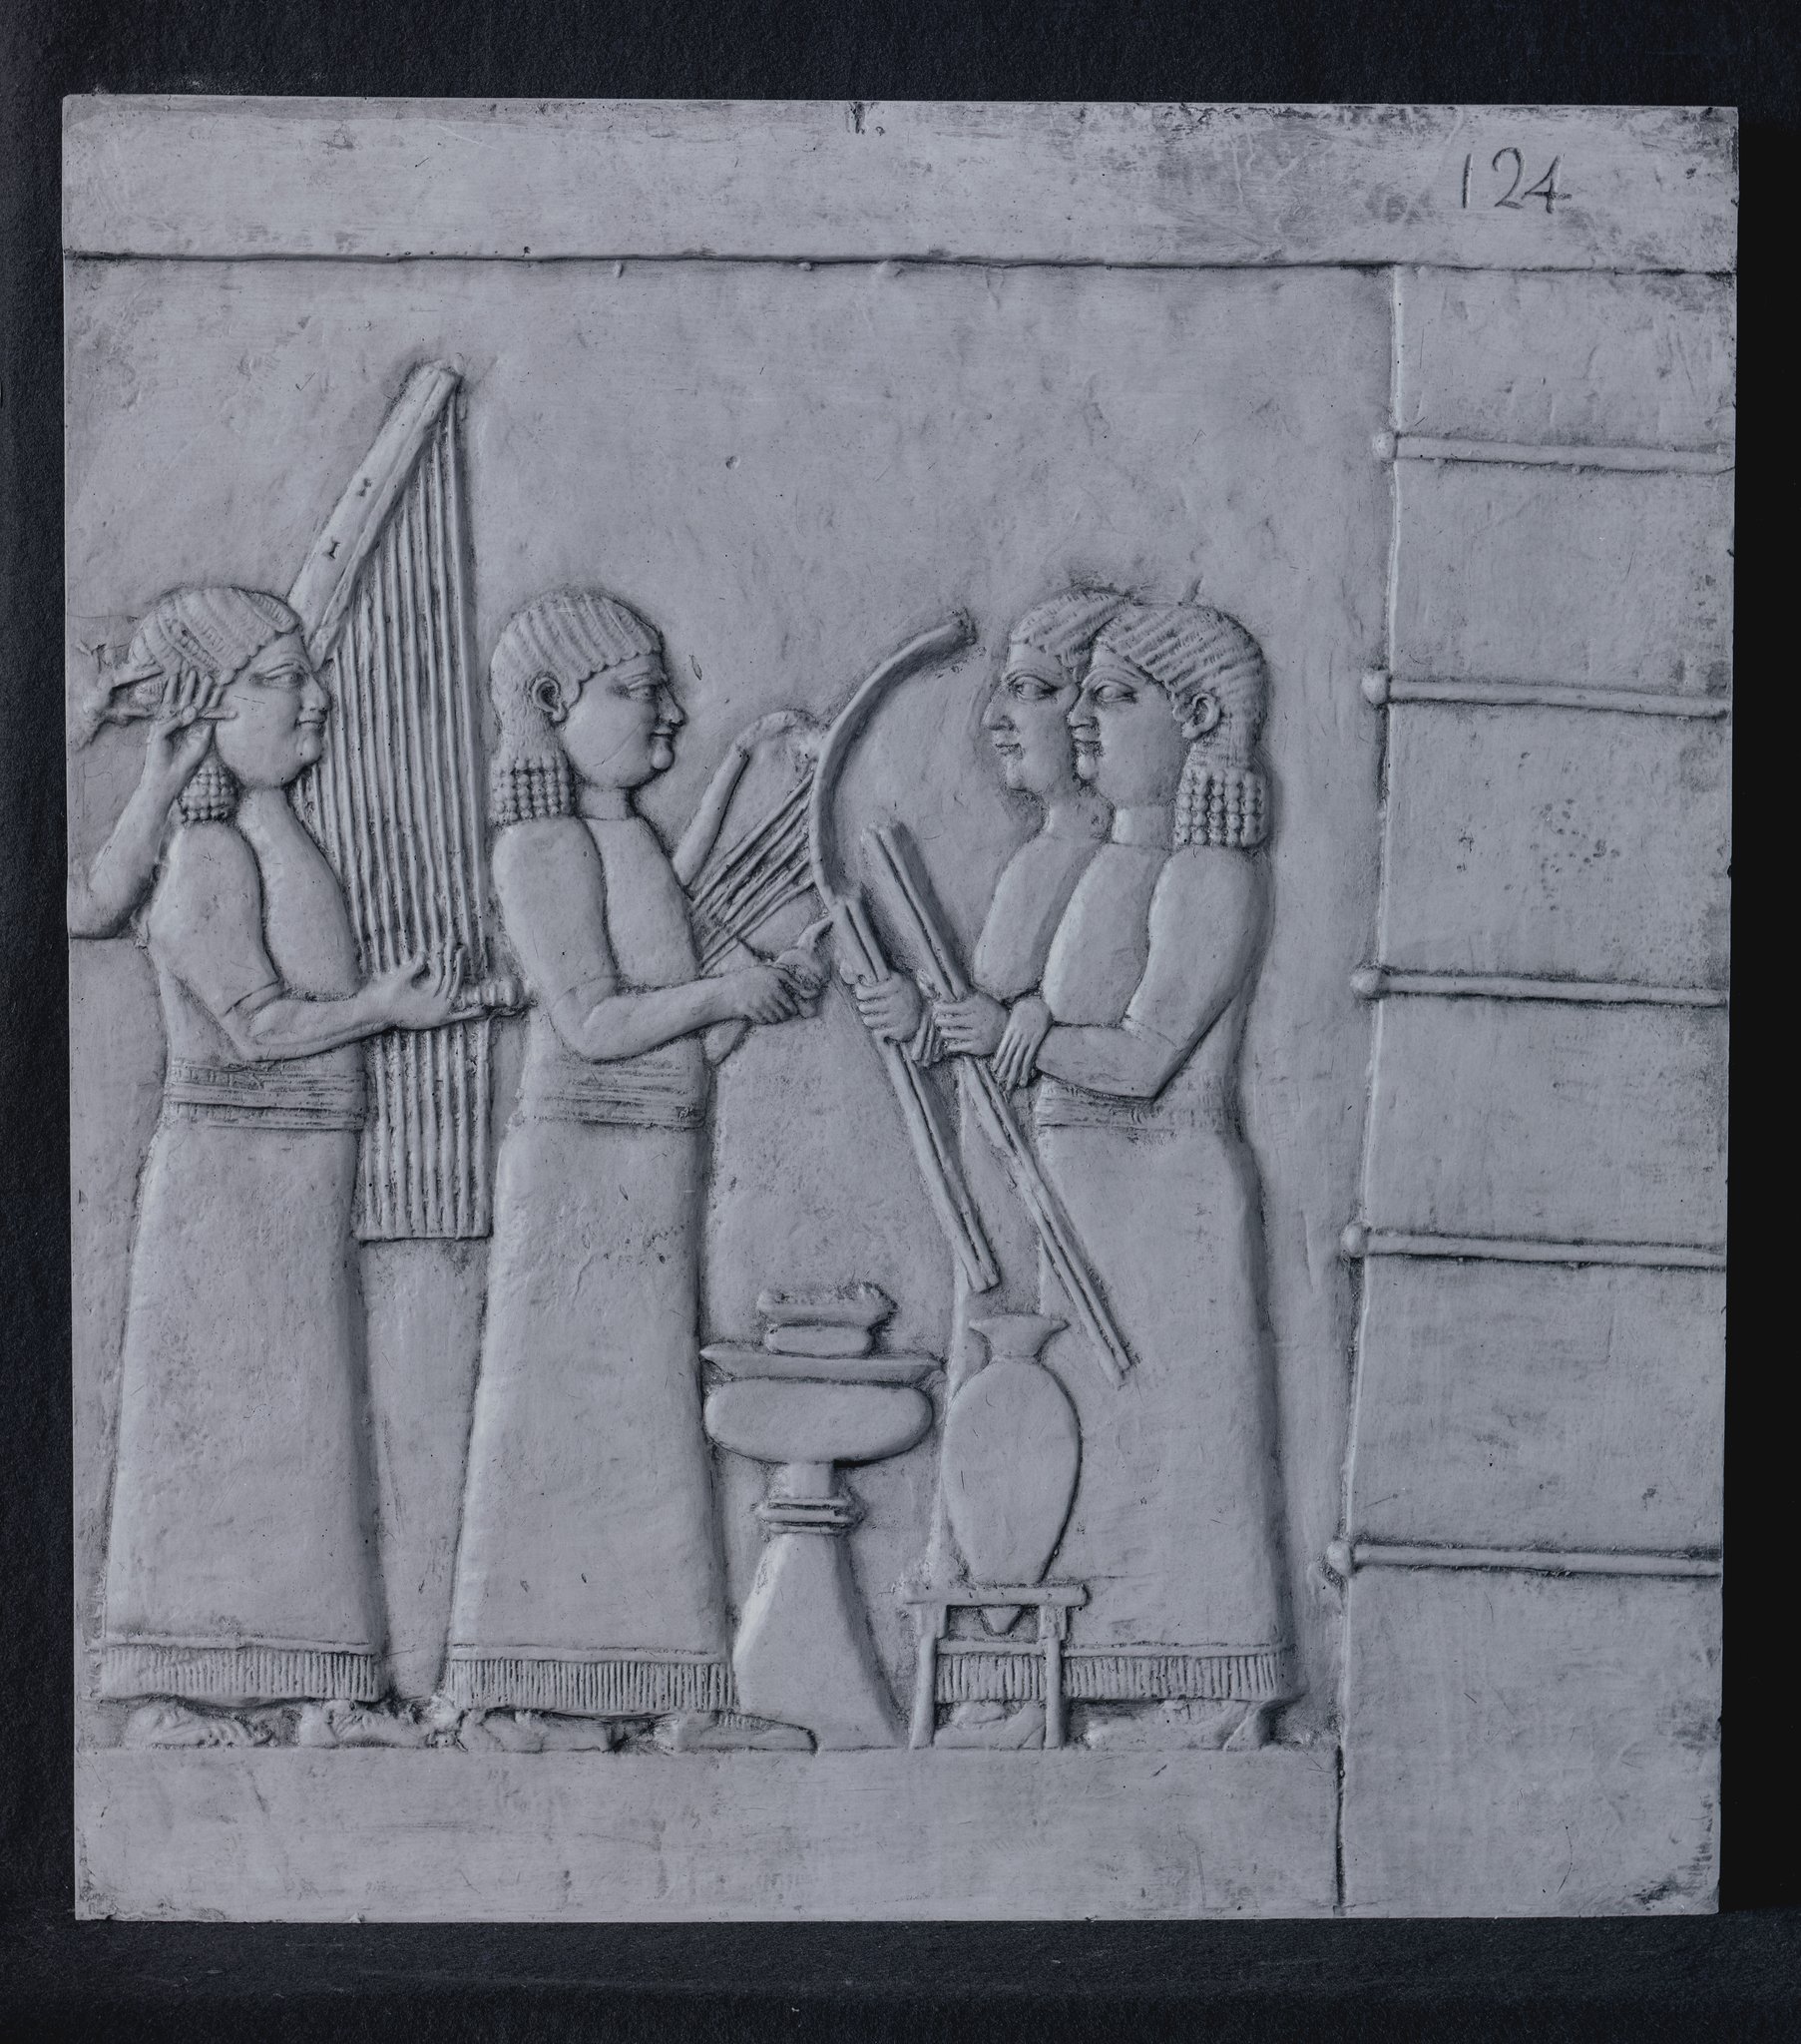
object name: cast of relief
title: Cast of relief: musicians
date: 7 BCE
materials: plaster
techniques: painting